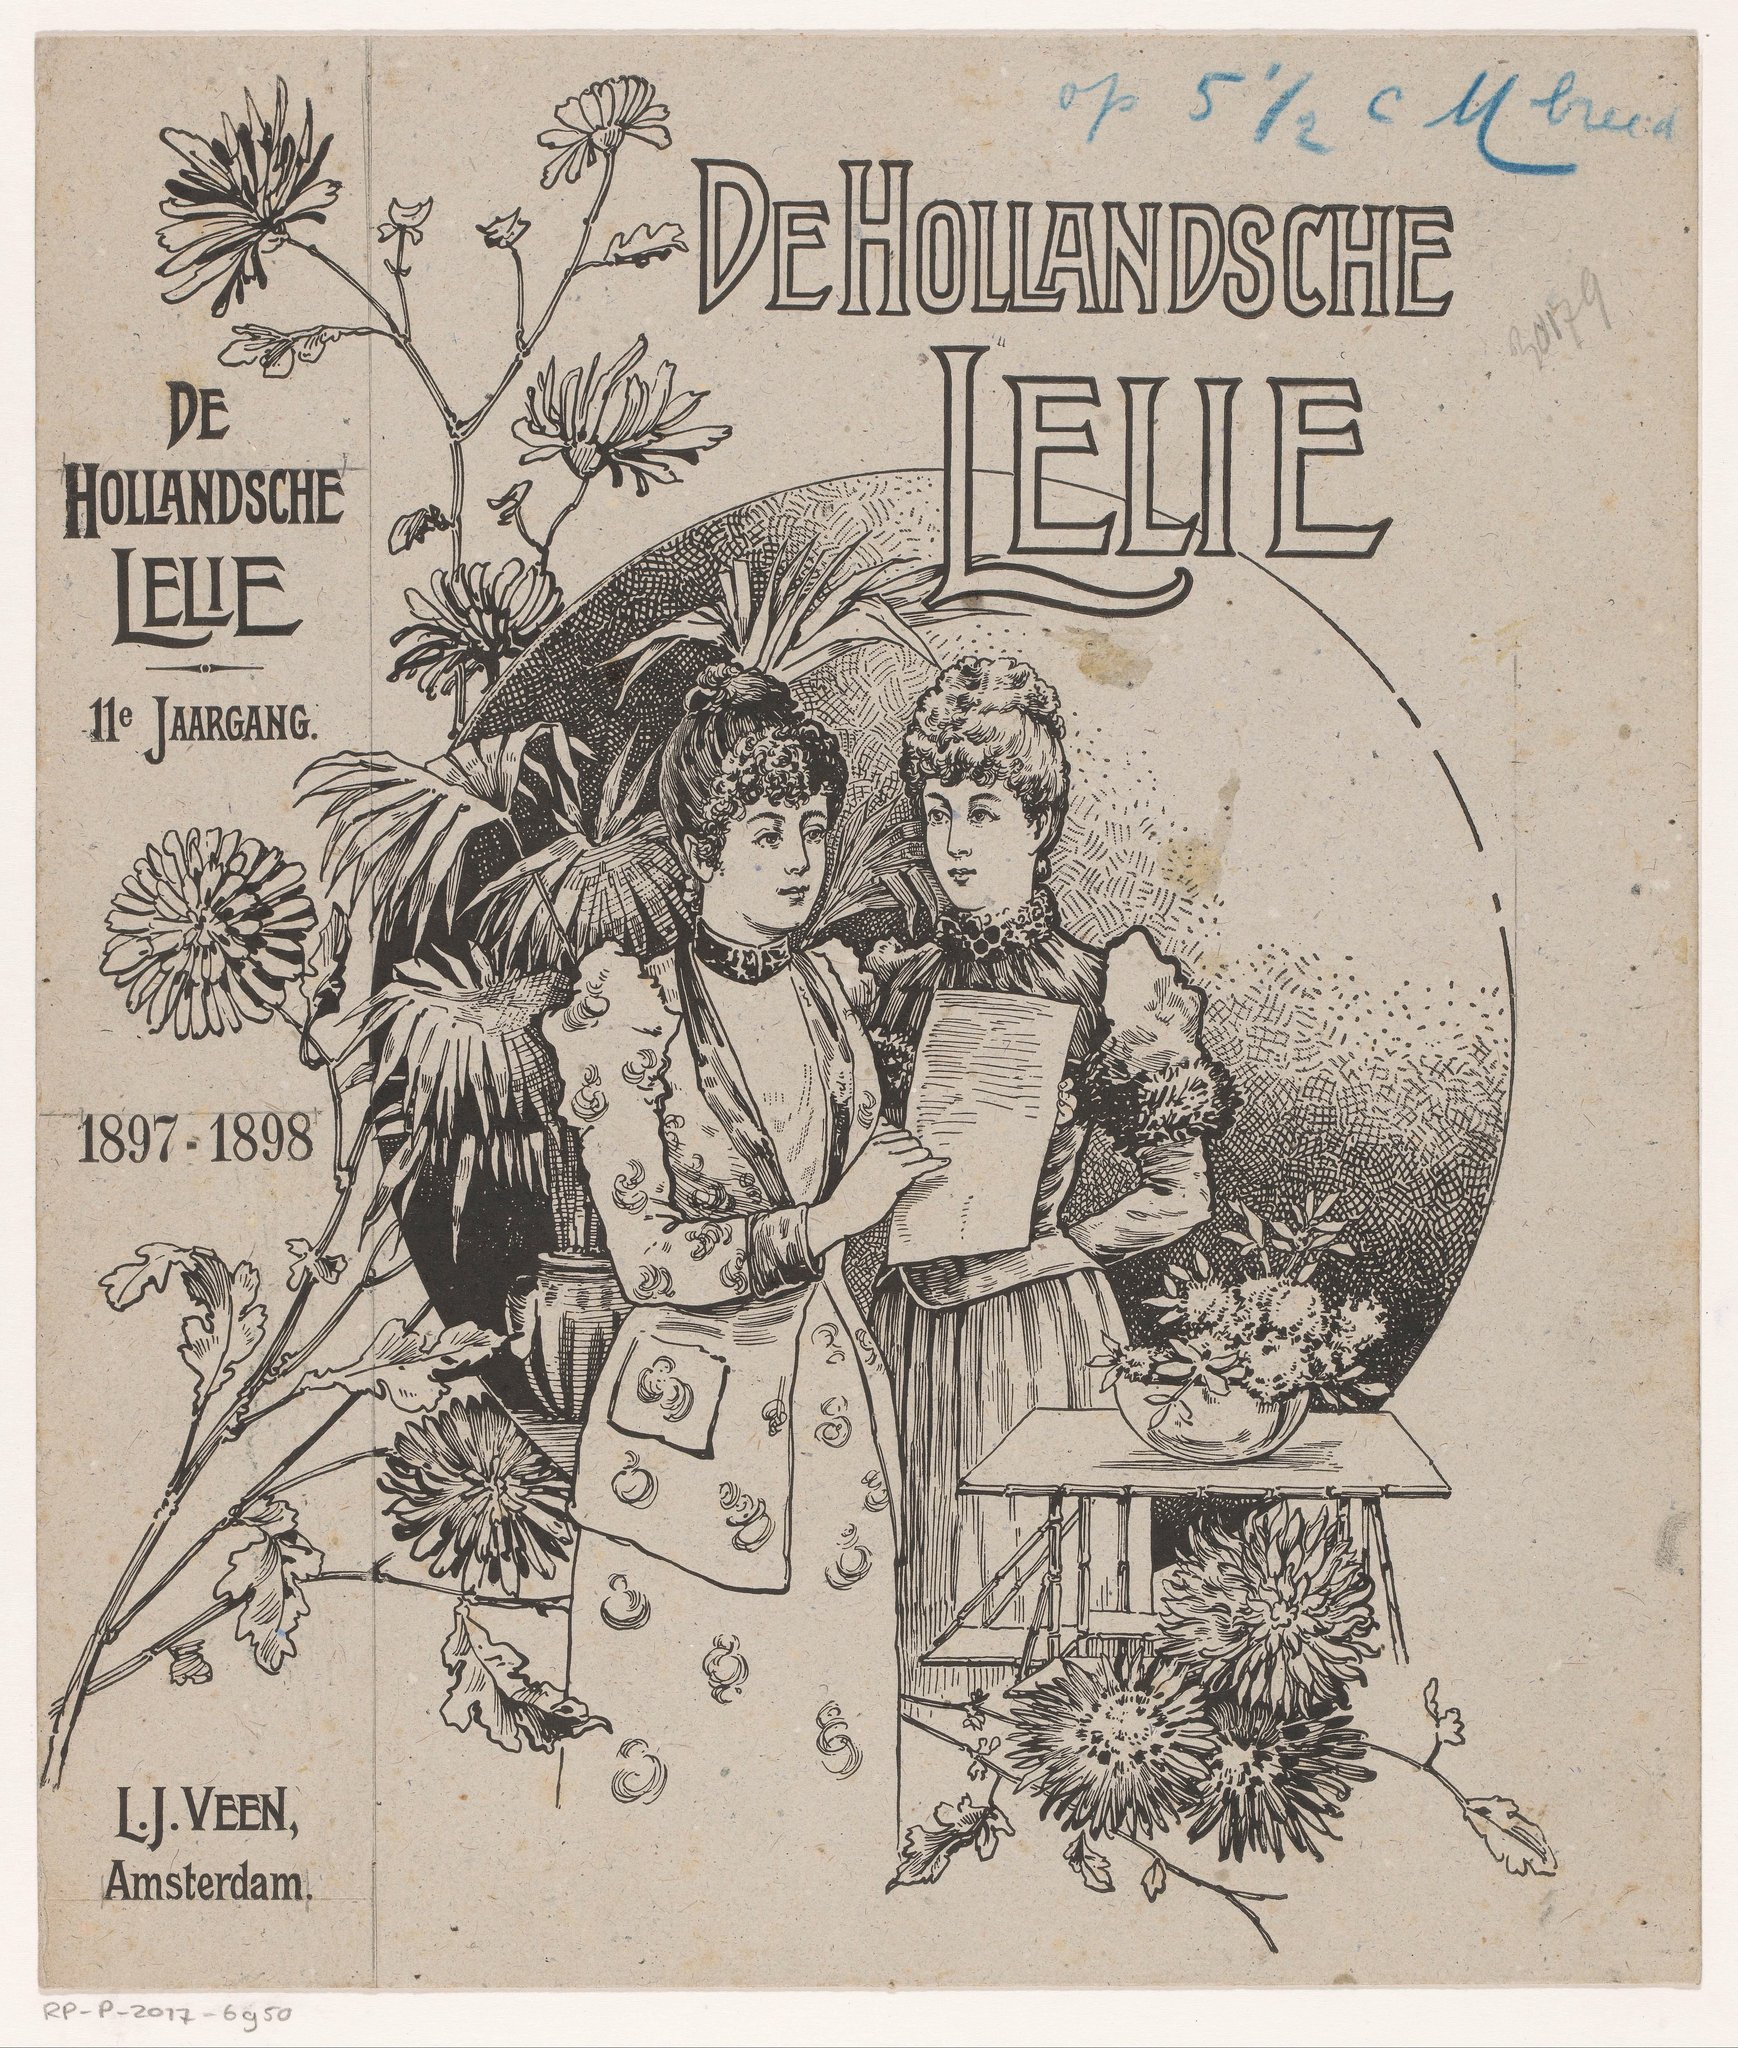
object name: study for binding design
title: Bandontwerp voor: De Hollandsche Lelie. Weekblad voor jonge dames, 11e jaargang, 1897-1898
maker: Anonymous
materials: cardboard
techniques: printing block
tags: plants (in general), flowers, weekly, monthly, magazine, etc.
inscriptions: collector's mark: Lugt 2228a, :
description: Ontwerp voor de band van tijdschrift 'De Hollandsche Lelie' met twee staande jonge vrouwen die een tijdschrift bekijken. Rond hen staan bloemen en planten, die deels doorlopen over de boekrug.